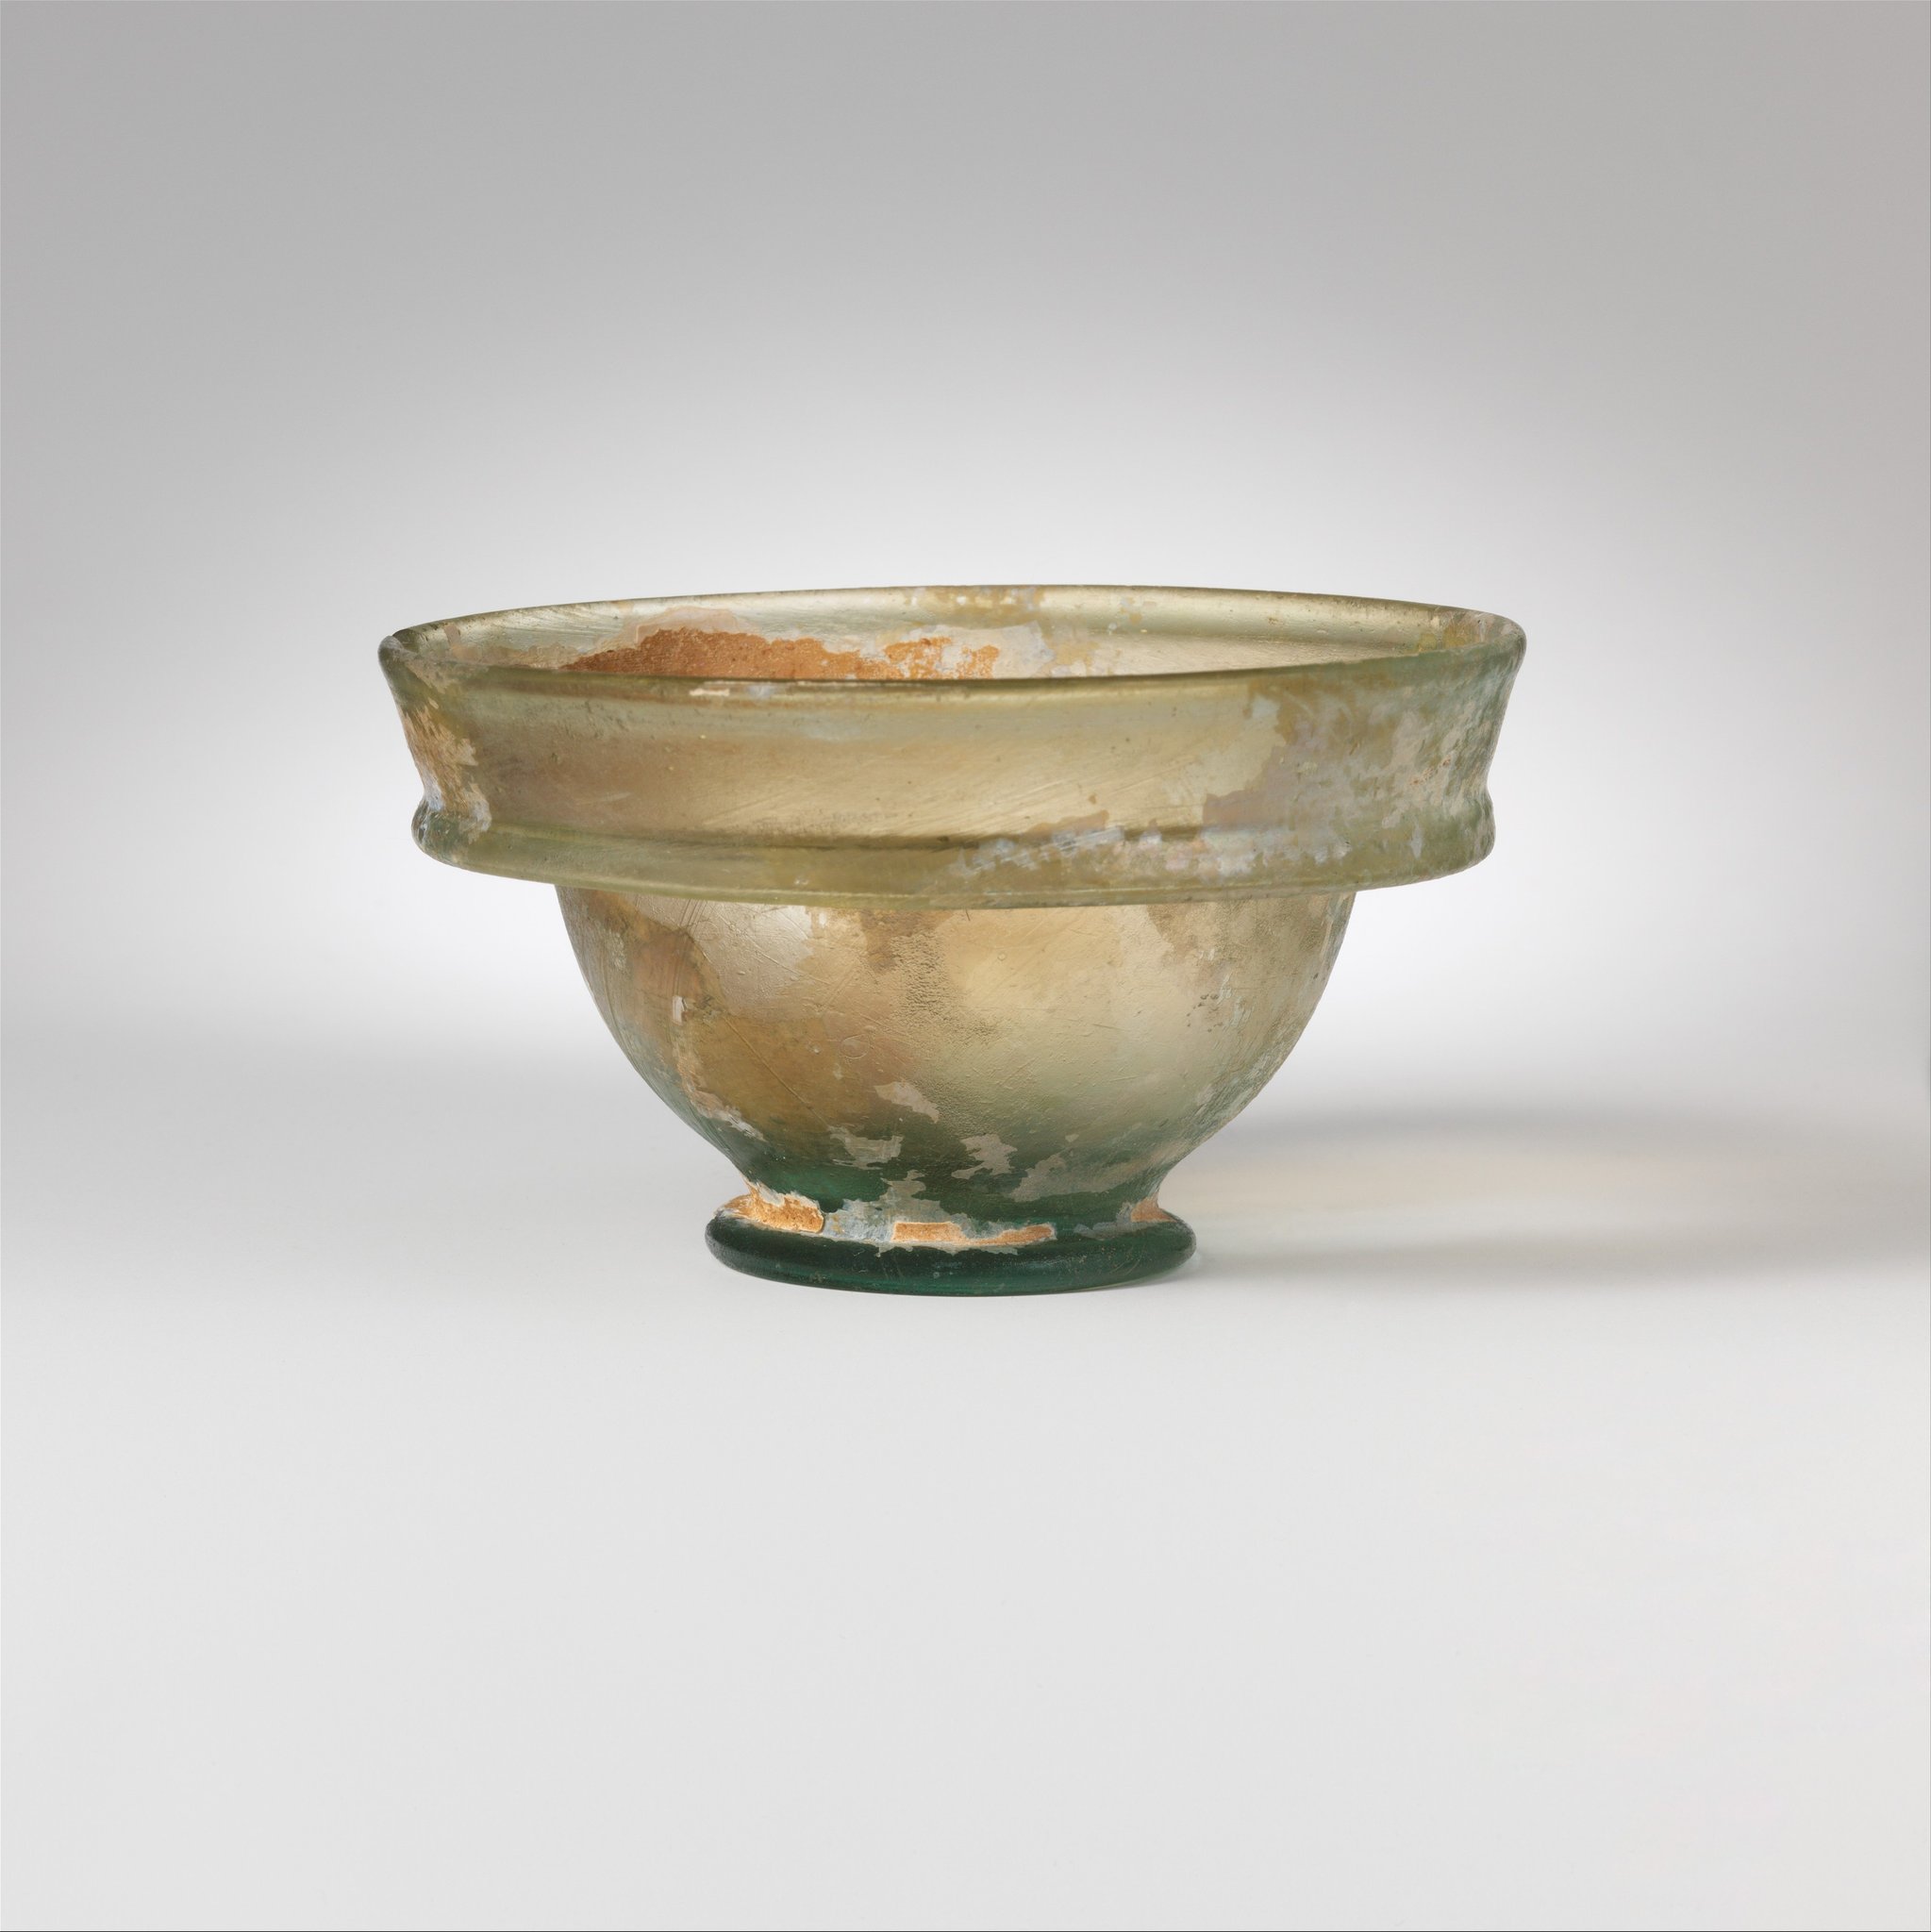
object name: bowl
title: Glass bowl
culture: roman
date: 1-100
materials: glass